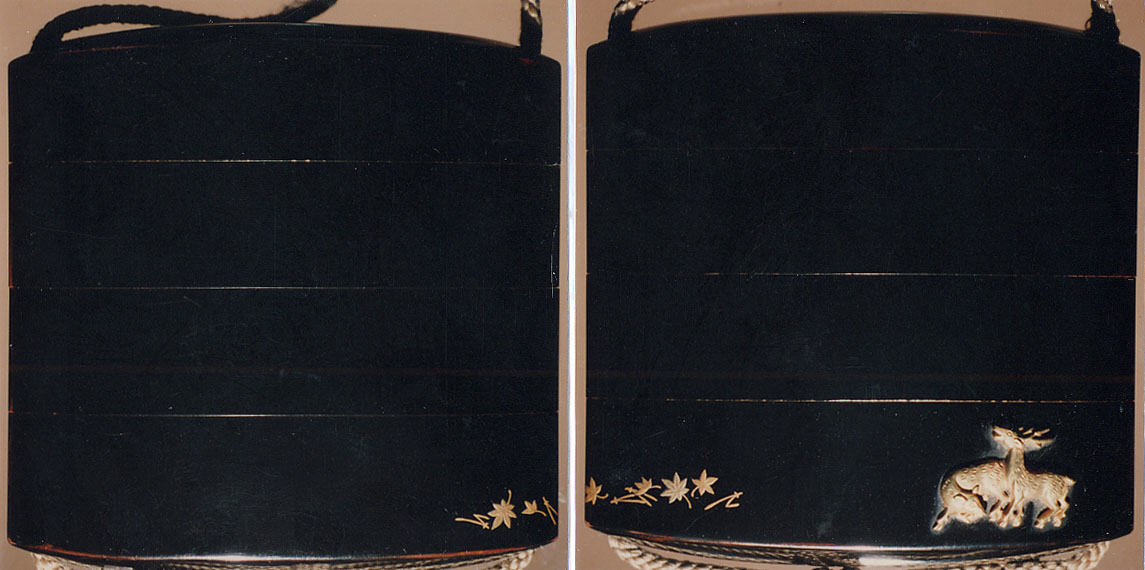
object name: inrō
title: Case (Inrō) with Design of Stag and Deer beside Pines Needles and Maple Leaves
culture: japanese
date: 1801-1900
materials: gold, lacquer, metal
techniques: fundame, hiramakie, roiro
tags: deer